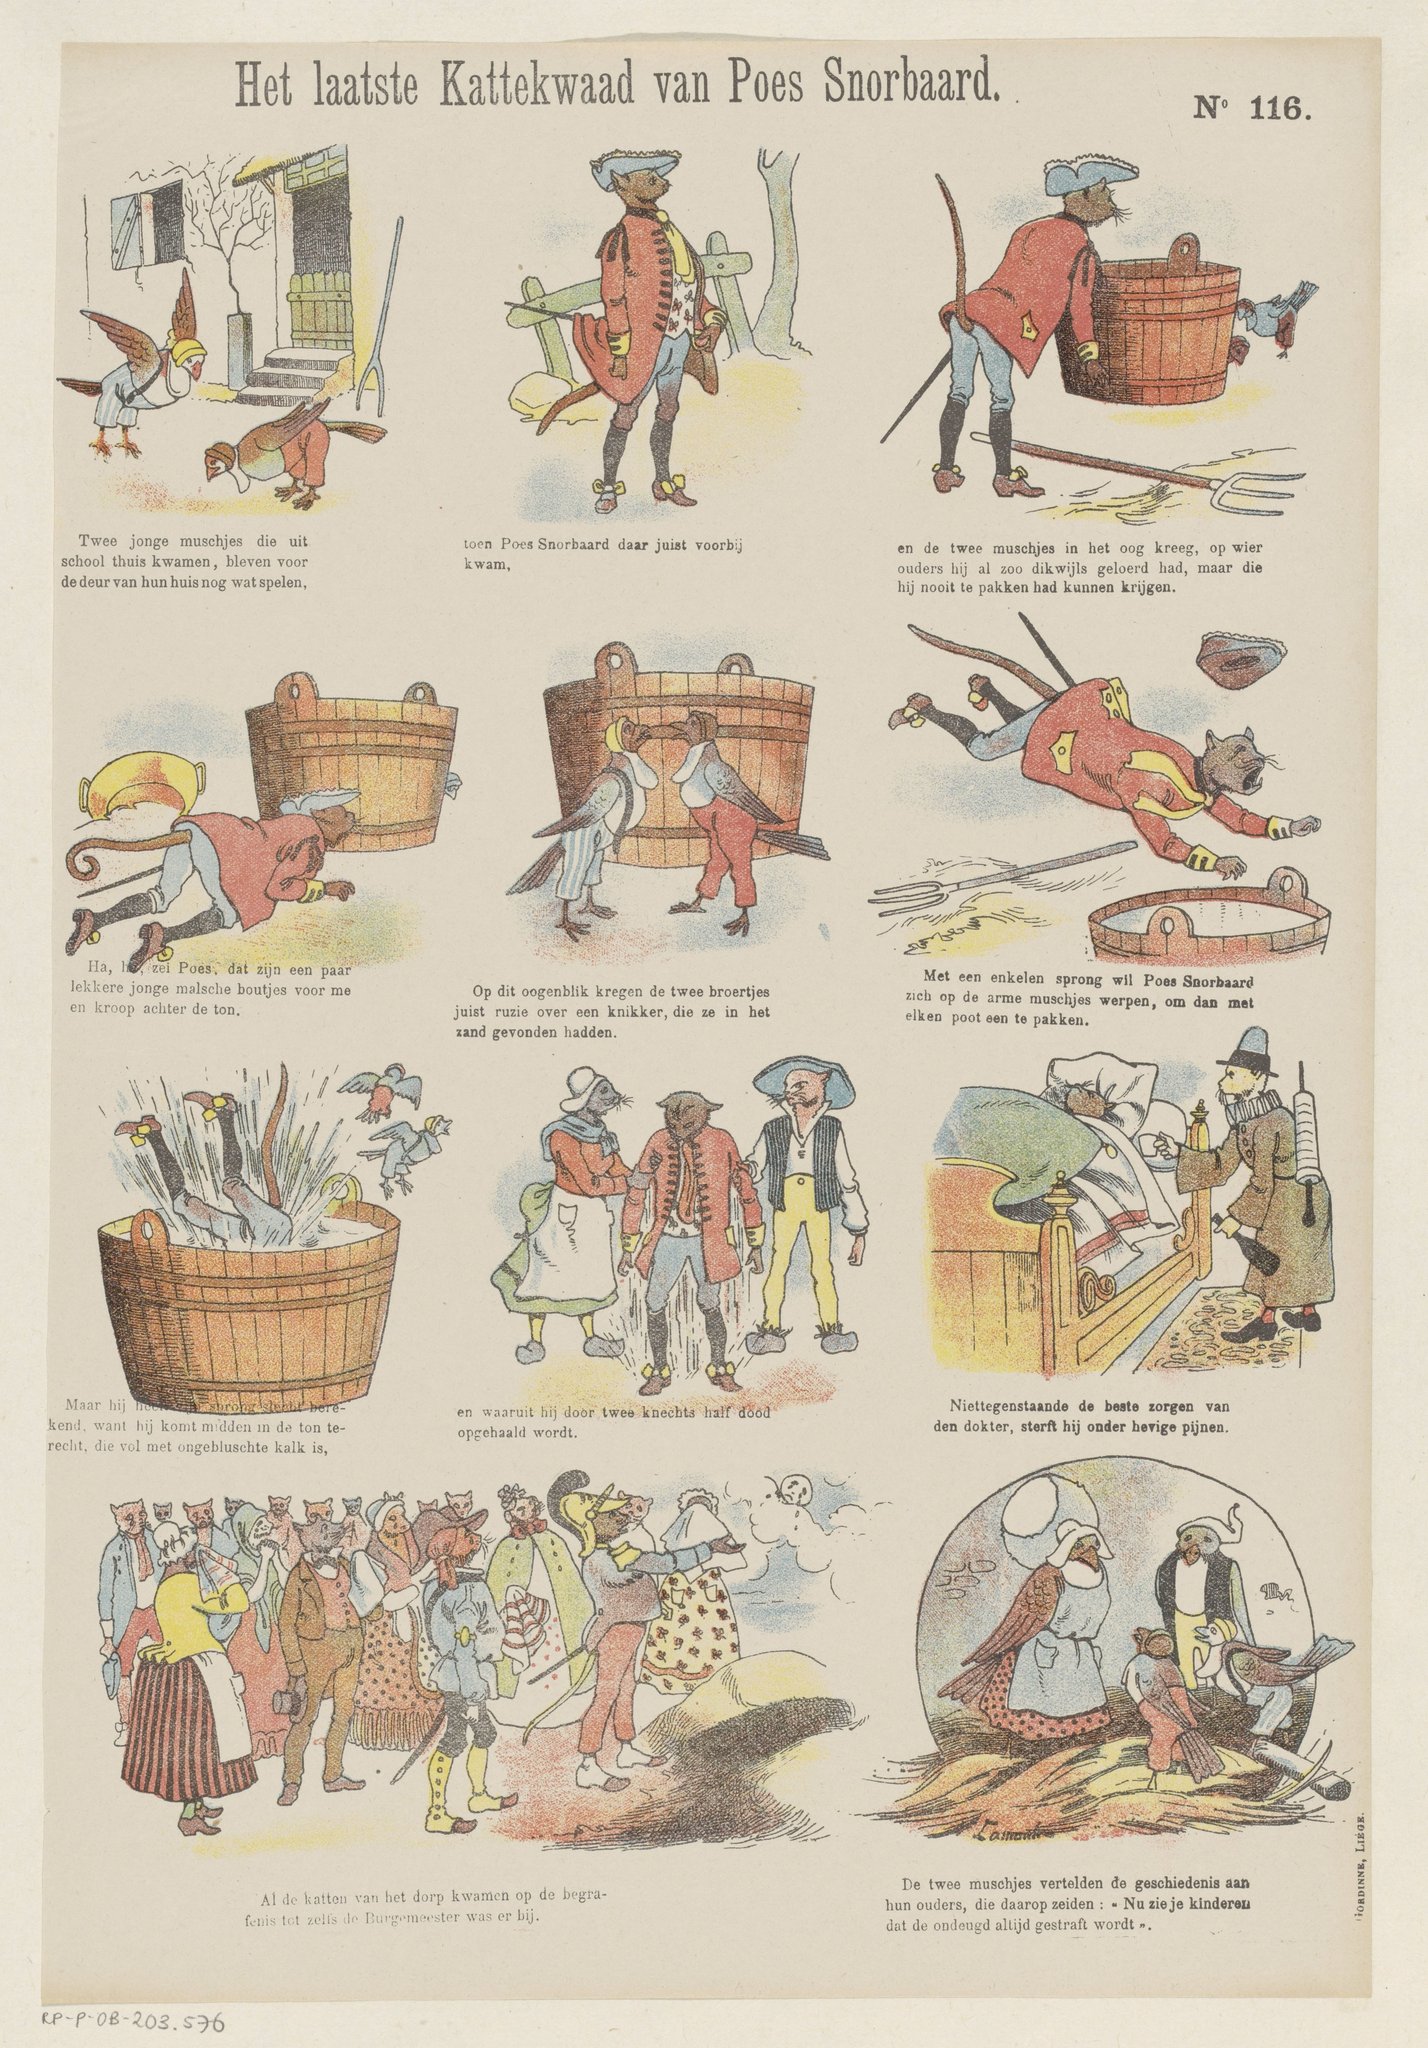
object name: popular print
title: Het laatste kattekwaad van Poes Snorbaart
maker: lamouche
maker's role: print maker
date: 1894-1959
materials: paper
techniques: lithograph, letterpress printing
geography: liège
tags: cat, animals acting as human beings, song-birds: sparrow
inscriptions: collector's mark: Lugt 2760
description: Blad met 11 voorstellingen over Poes Snorbaart die sterft nadat hij twee mussen probeerde te vangen. Onder elke afbeelding een onderschrift. Genummerd rechtsboven: No 116.